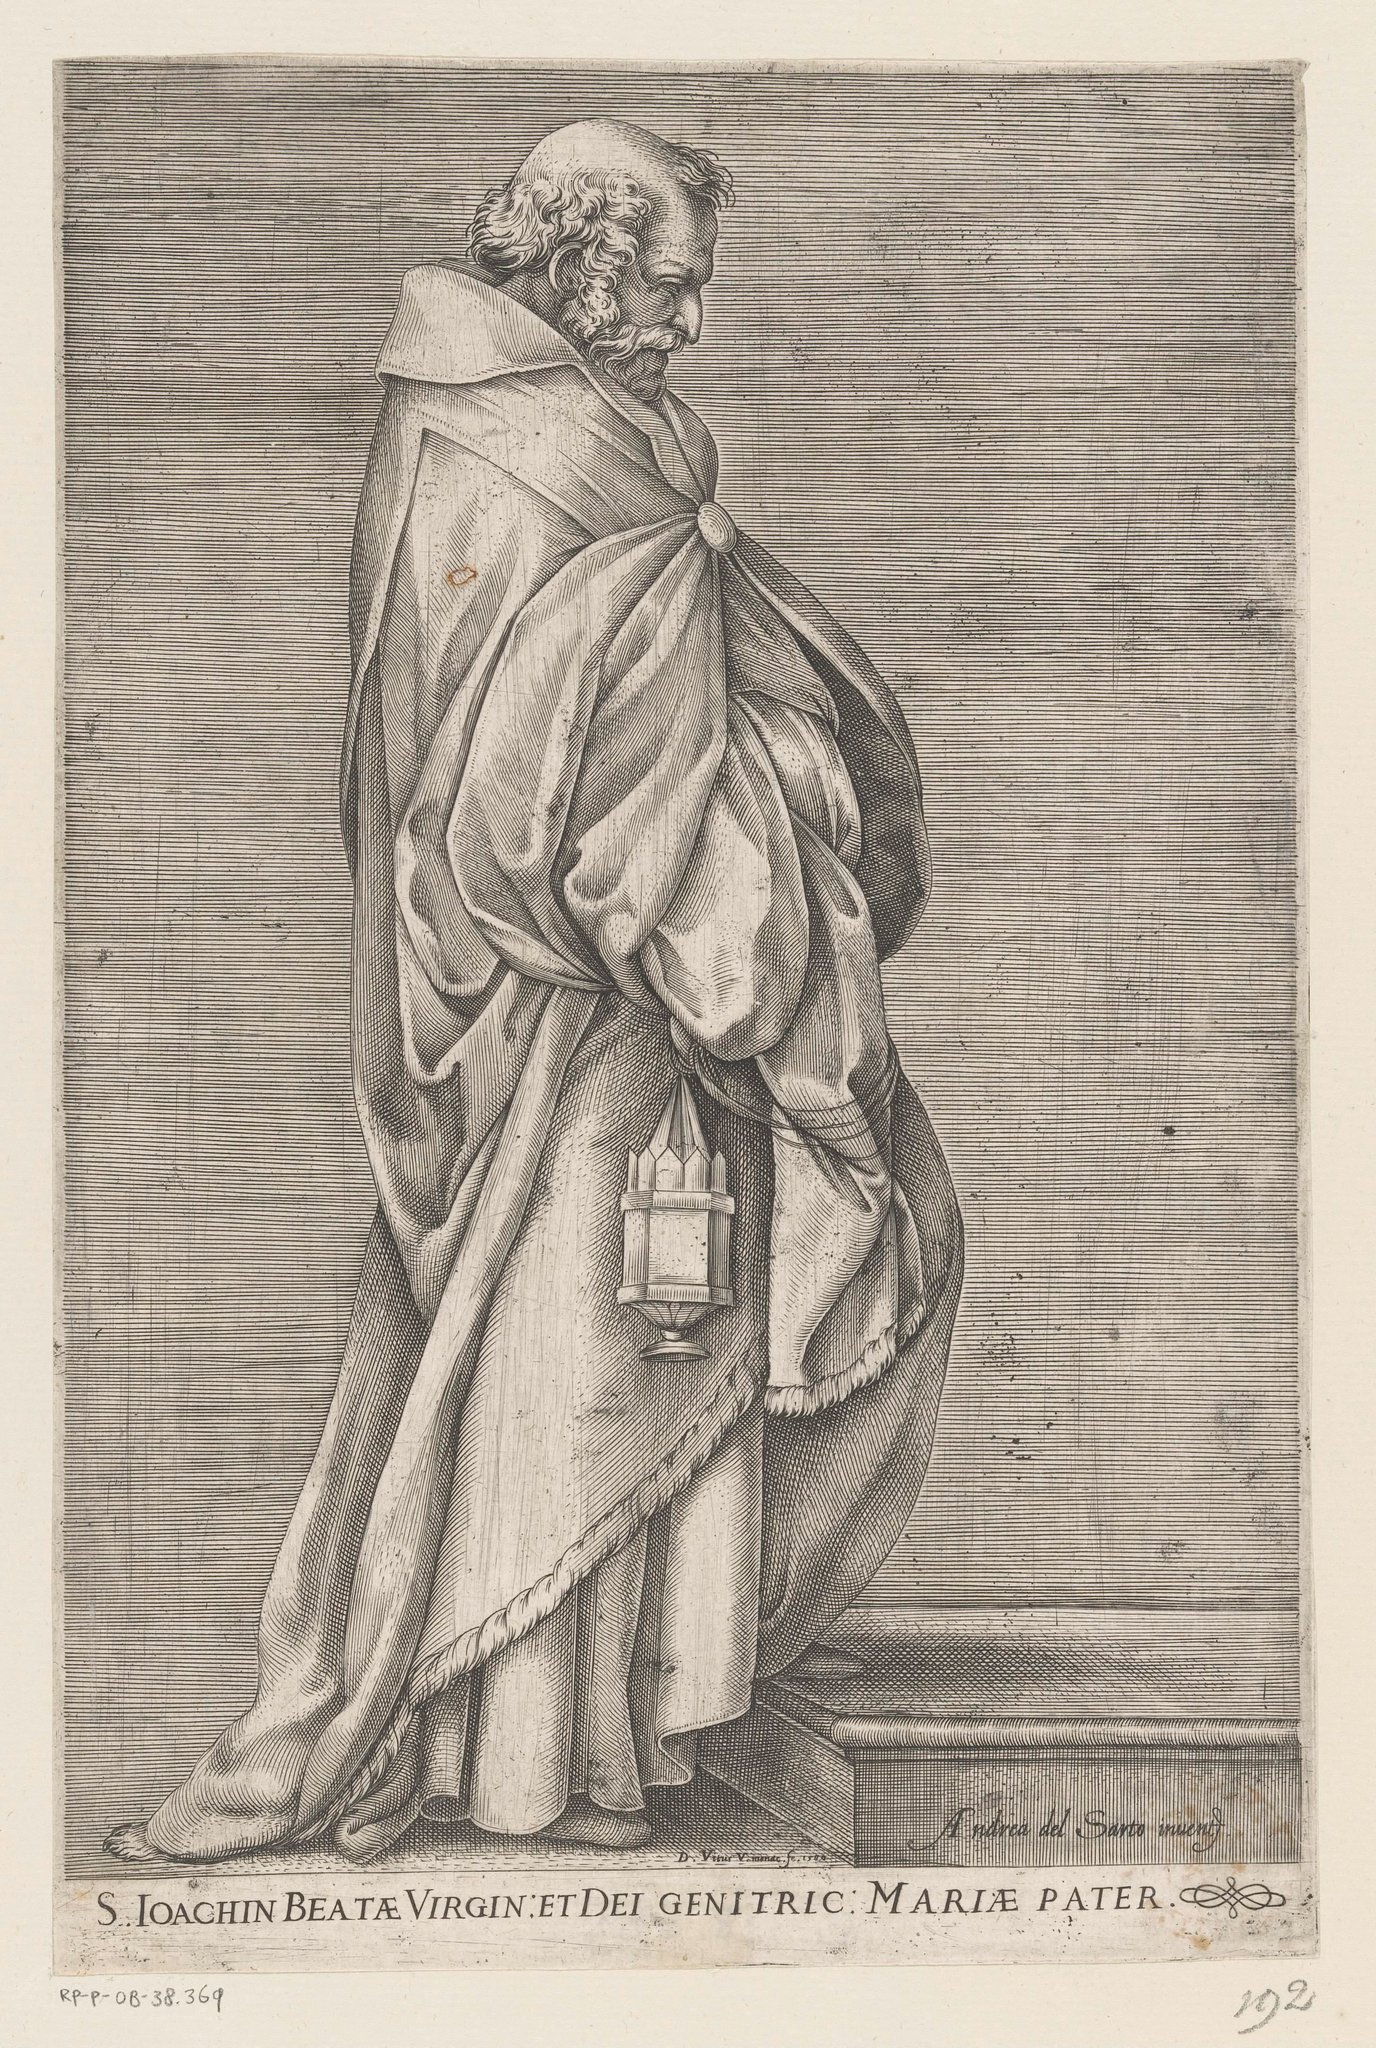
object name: print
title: Hogepriester Zacharias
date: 1580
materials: paper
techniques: engraving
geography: italy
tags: the father of mary, joachim; possible attributes: book, two doves, lamb, (shepherd's) staff, annunciation of the birth of john the baptist to zacharias: while he is offering incense in the temple an angel (gabriel) appears to him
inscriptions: collector's mark: Lugt 240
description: De hogepriester Zacharias met wierookvat. Aan Zacharias werd door de engel Gabriël de geboorte van Johannes de Doper voorspeld. De engel verscheen aan Zacharias op het moment dat hij wierook offerde in de tempel. In de ondermarge wordt de figuur foutief geïdentificeerd als de Heilige Joachim, de vader van Maria.